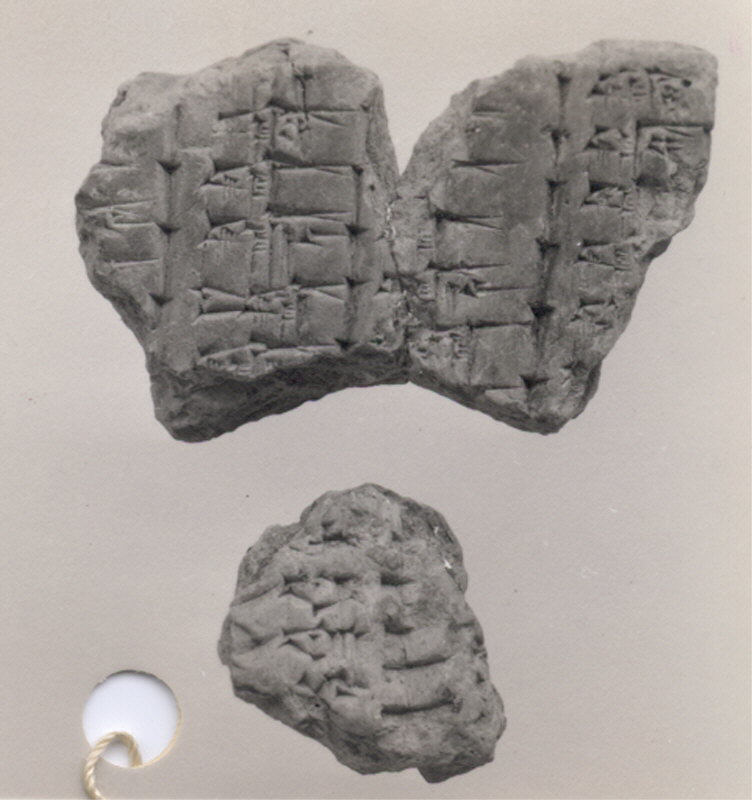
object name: cuneiform tablet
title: Cuneiform tablet: fragment of Syllabary A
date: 333-1 BCE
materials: clay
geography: mesopotamia